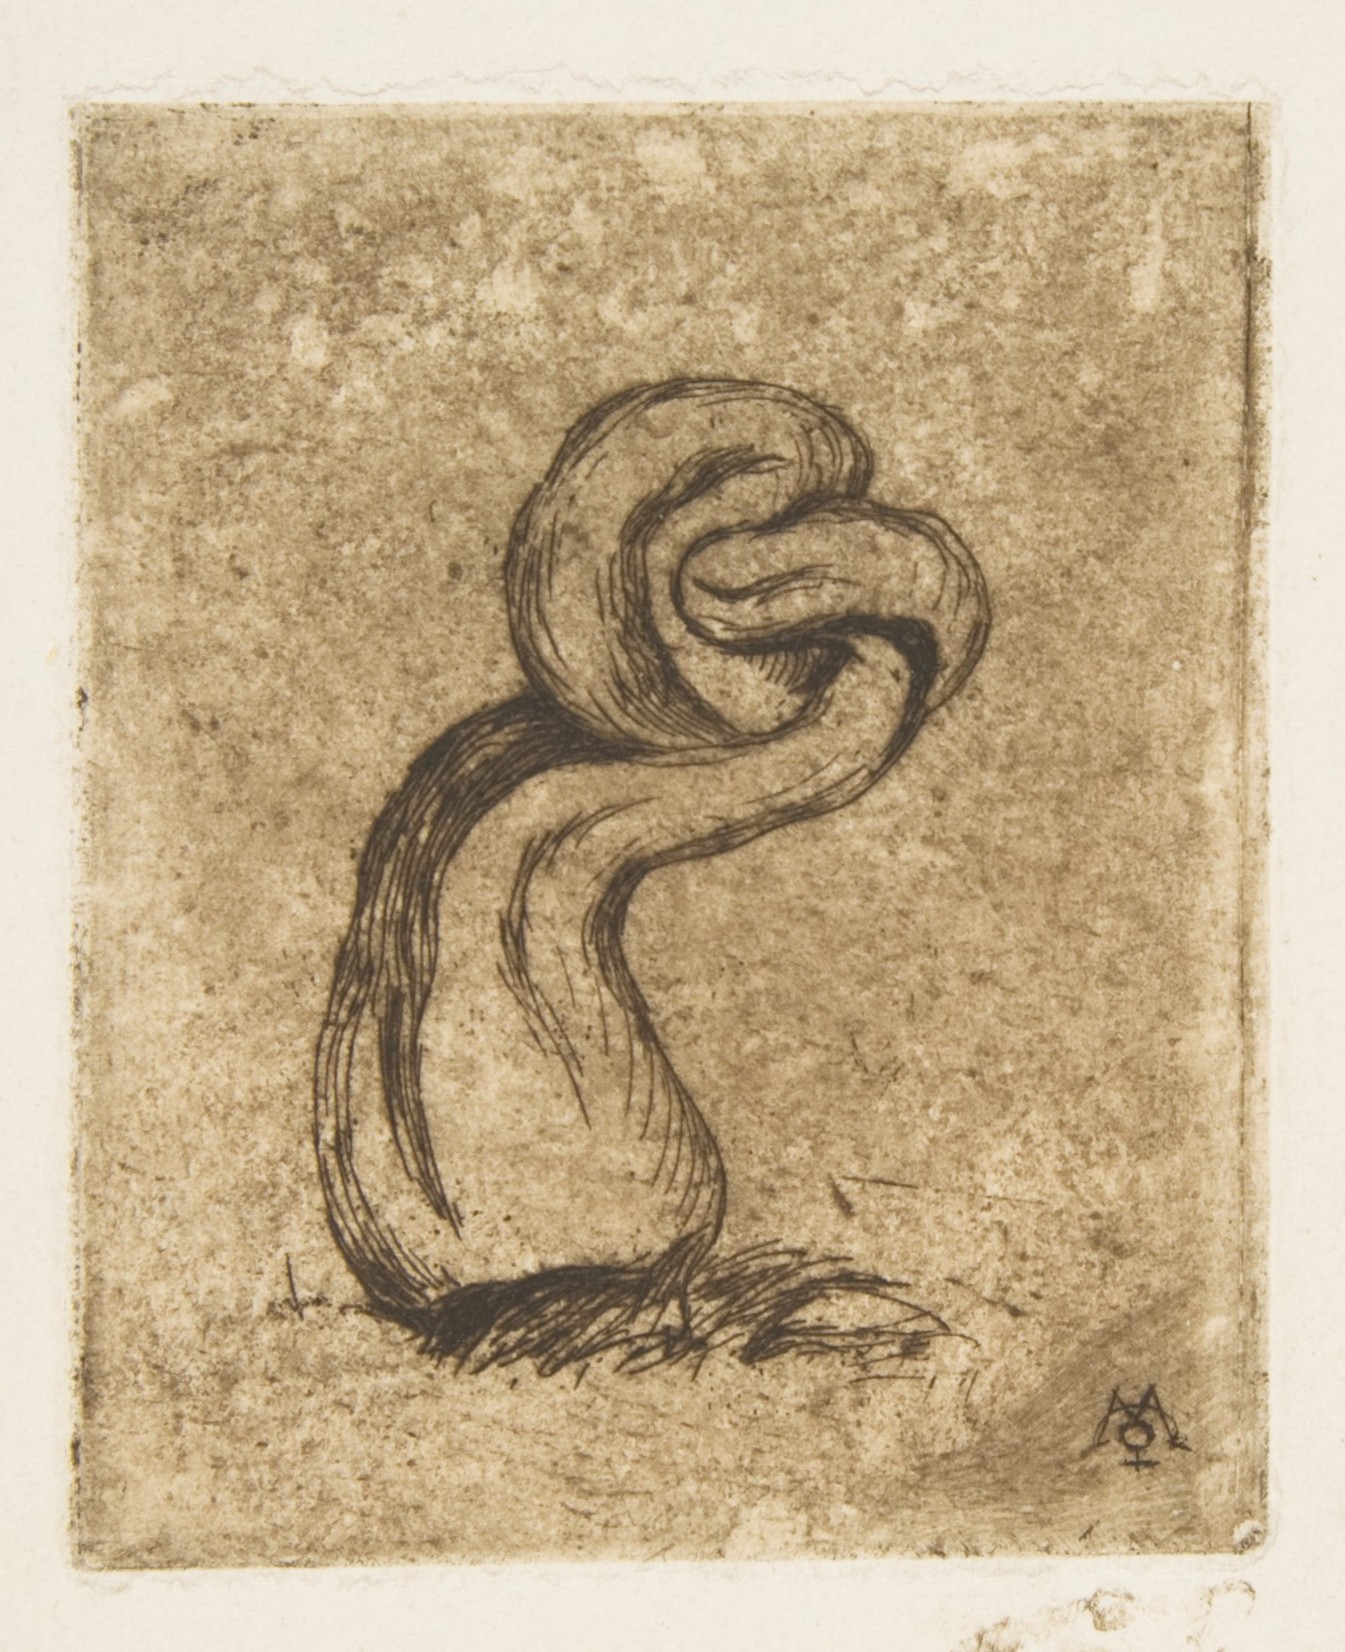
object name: print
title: The Puny Cryptogamia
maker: charles meryon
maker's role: artist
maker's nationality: french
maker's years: 1821-1868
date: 1860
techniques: etching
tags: plants